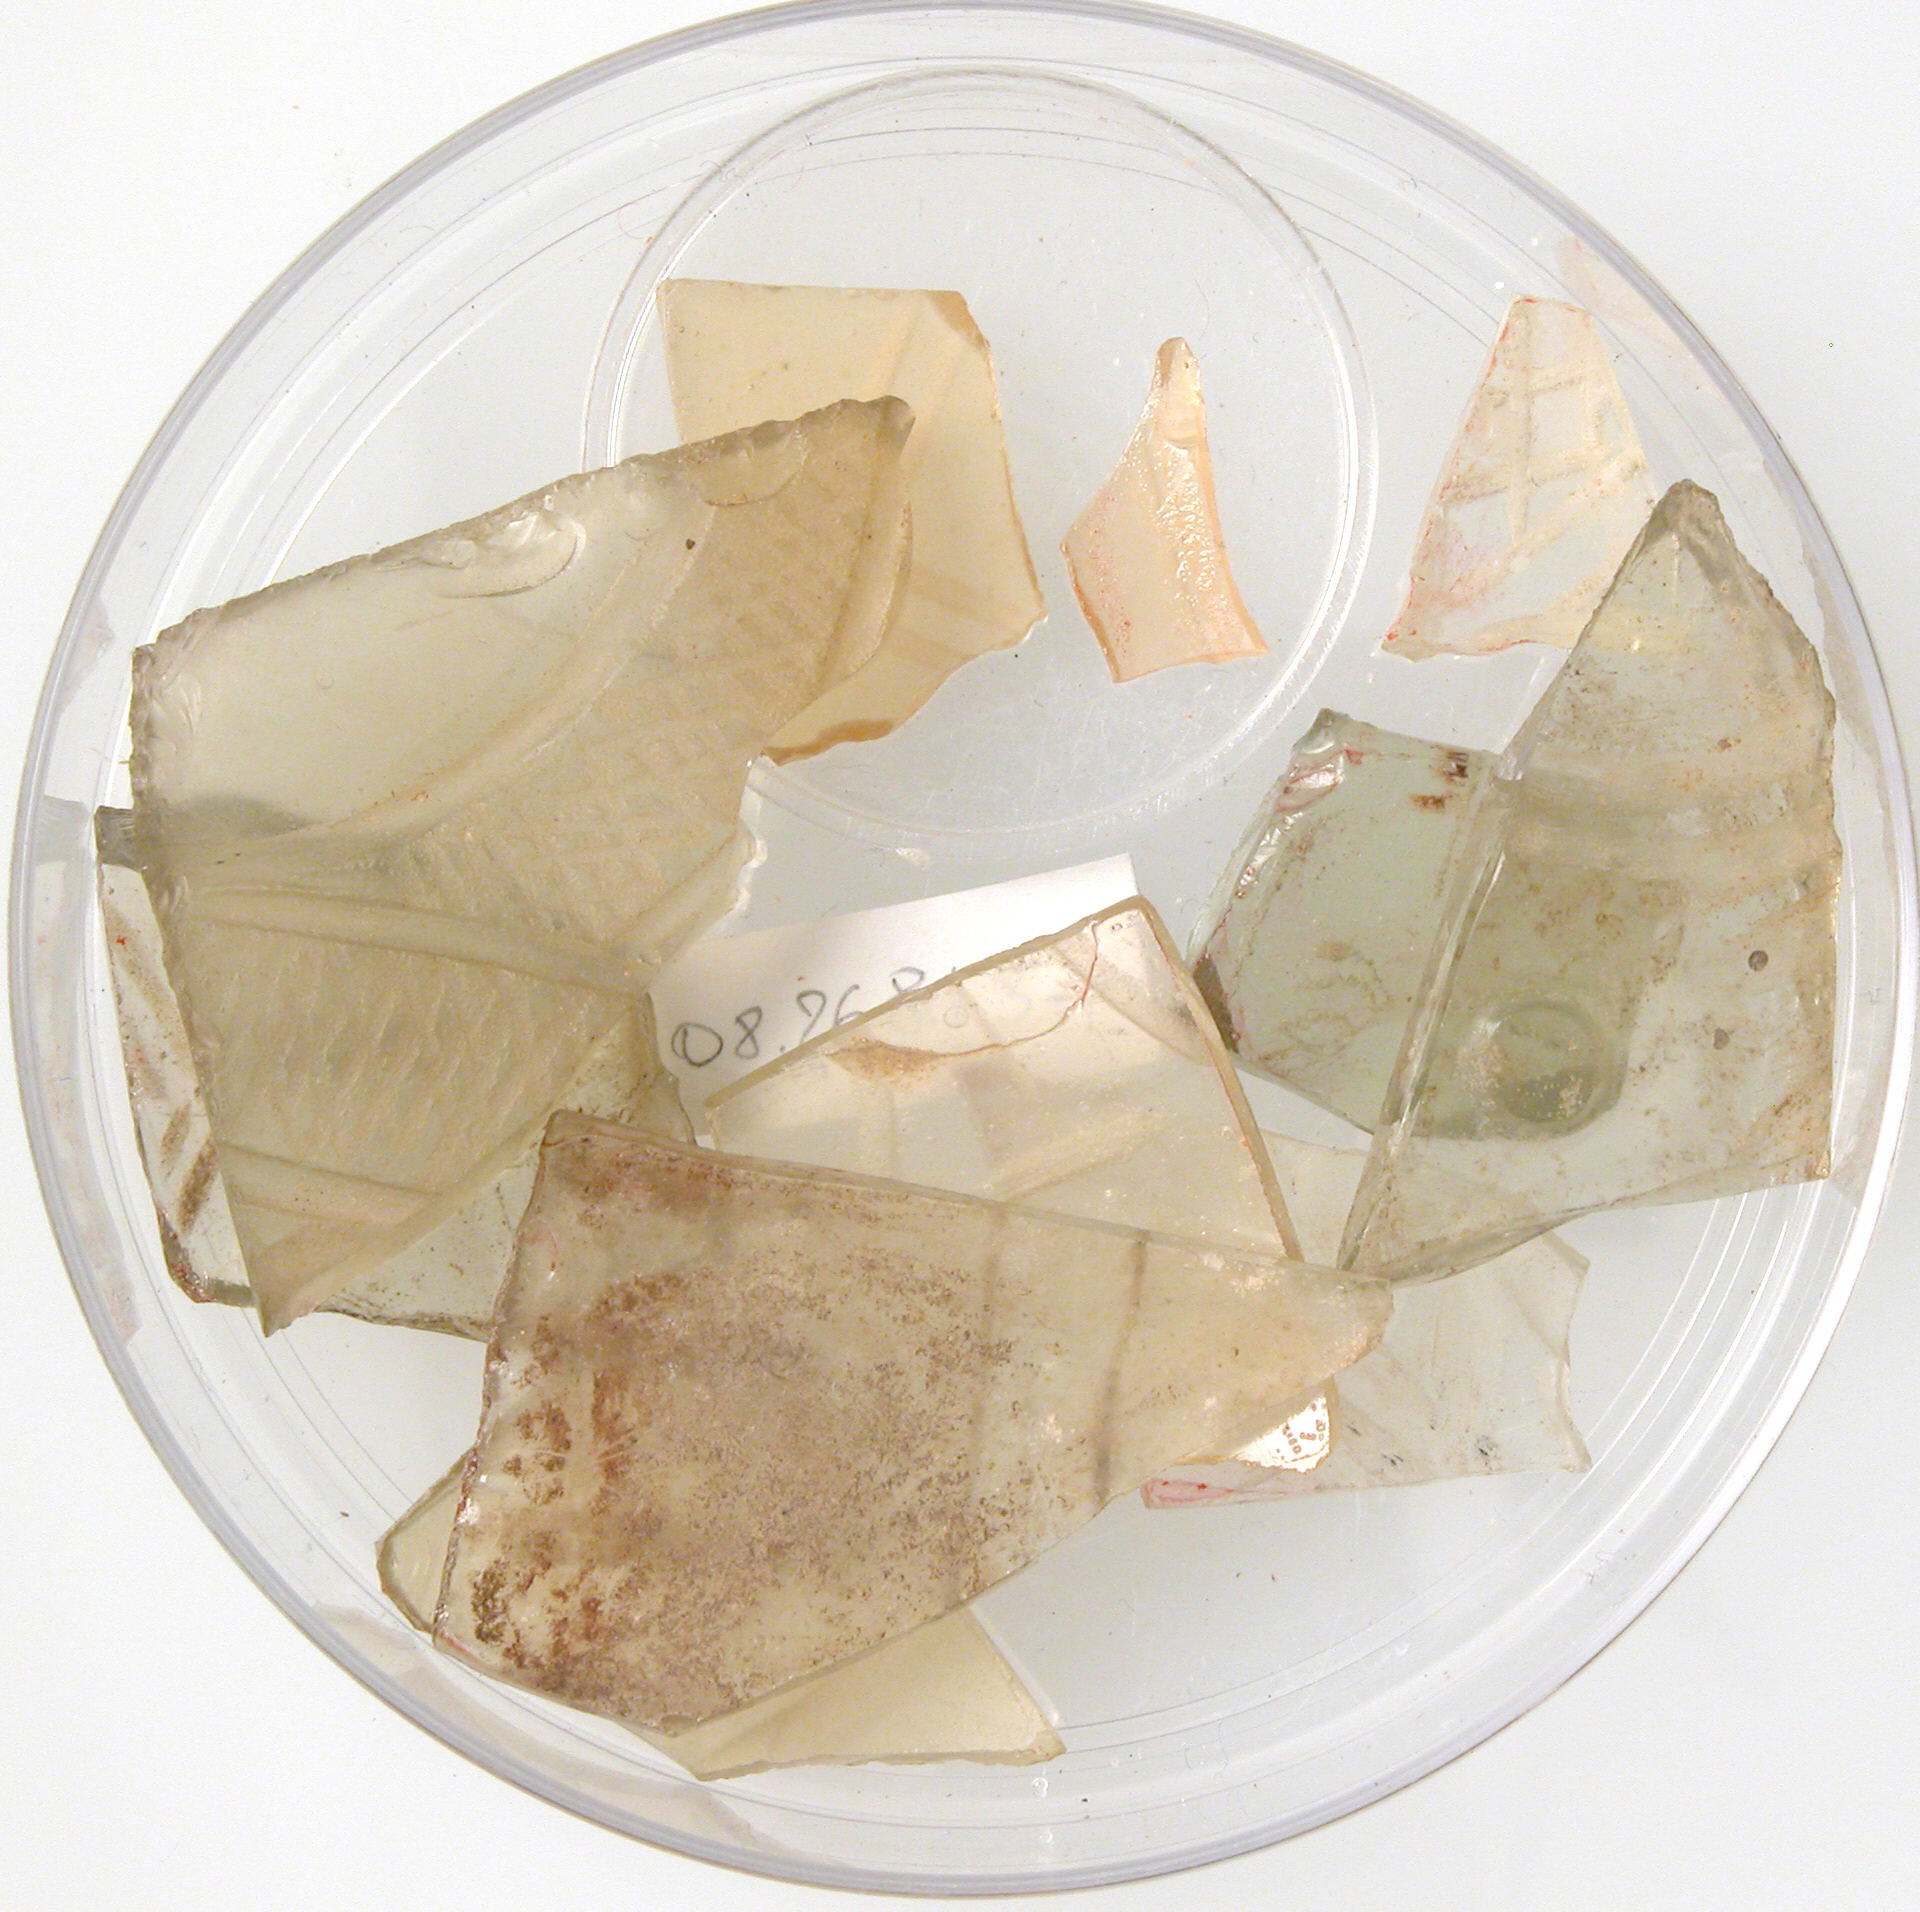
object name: fragment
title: Glass Fragments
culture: coptic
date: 301-433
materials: glass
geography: egypt